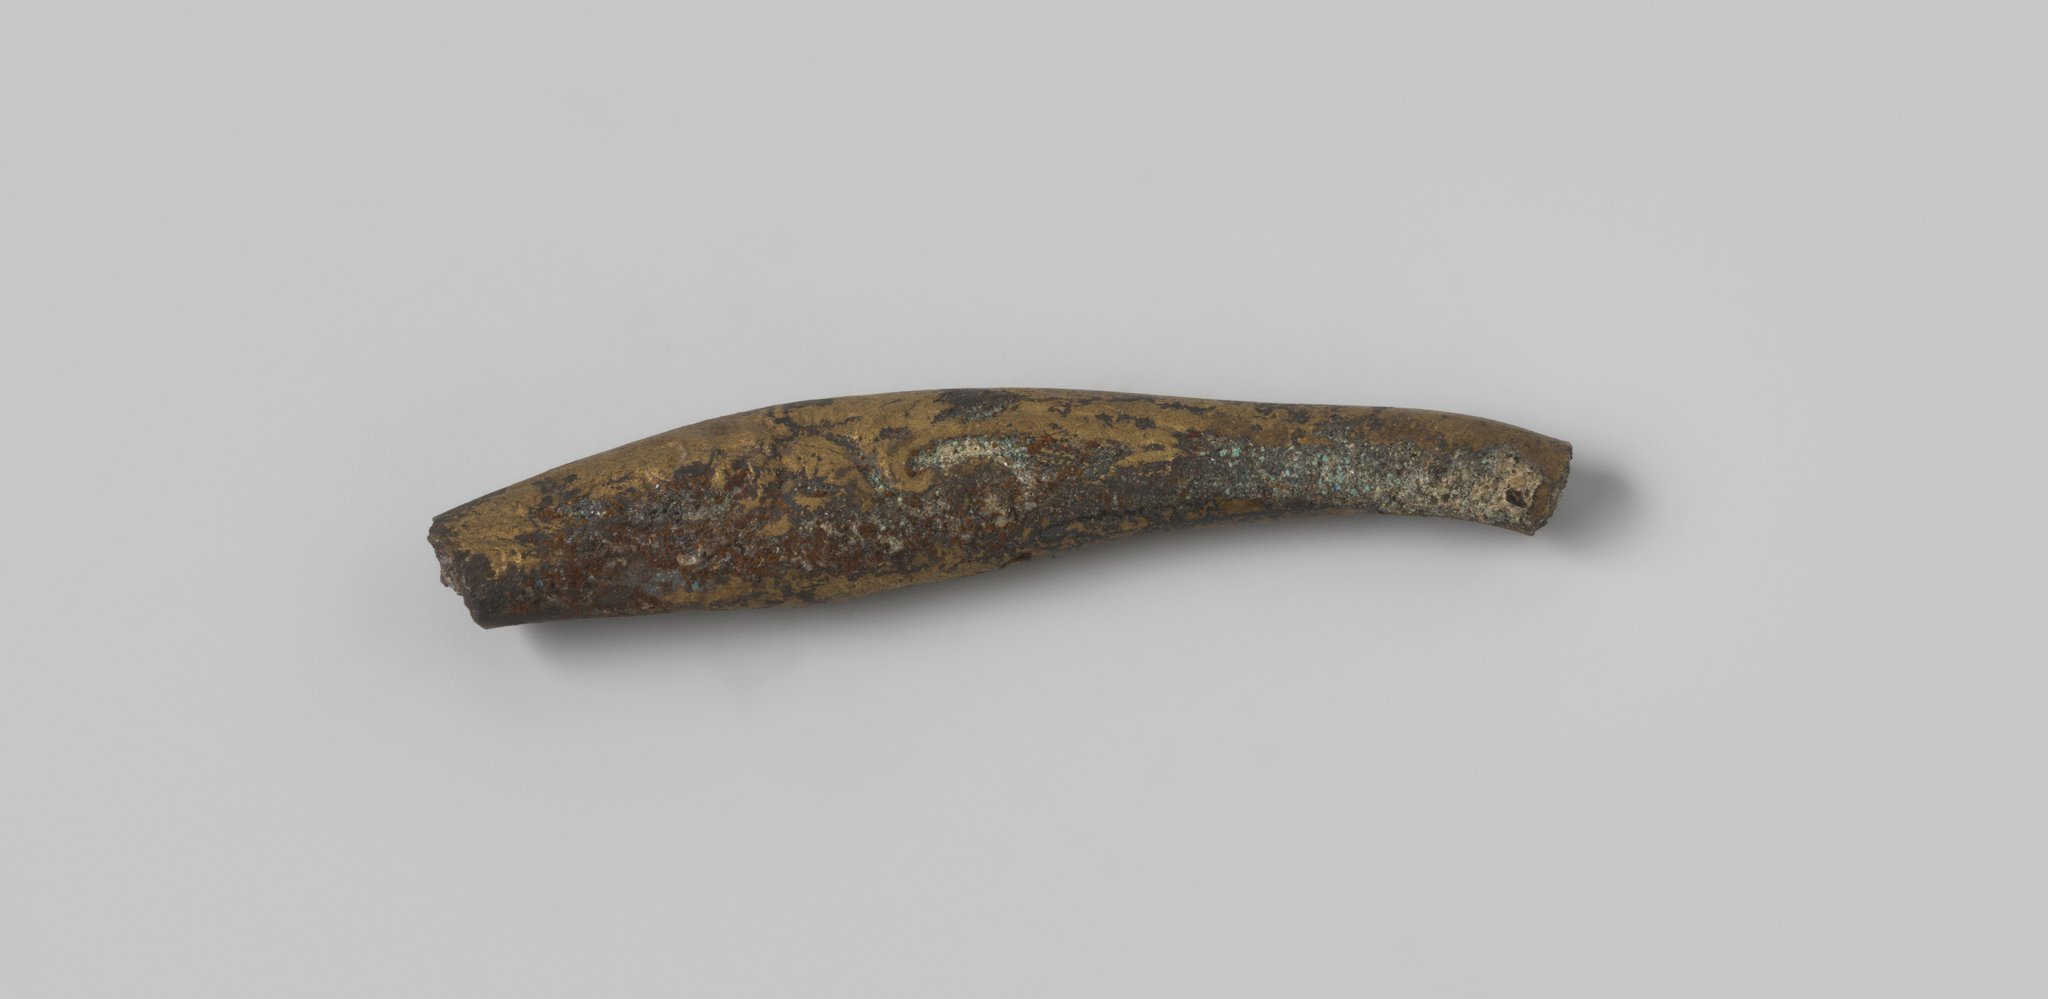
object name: beugel gevestl, gevestbeugel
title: Fragment beugel van gevest uit het wrak van de Oost-Indiëvaarder Hollandia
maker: Anonymous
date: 1700-1743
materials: copper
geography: netherlands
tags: verenigde oostindische compagnie, hollandia (schip), annet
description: Hilt, guard, fragm of knuckle-guard, central bulbous part, flat oval in section, scroll motif decoration.